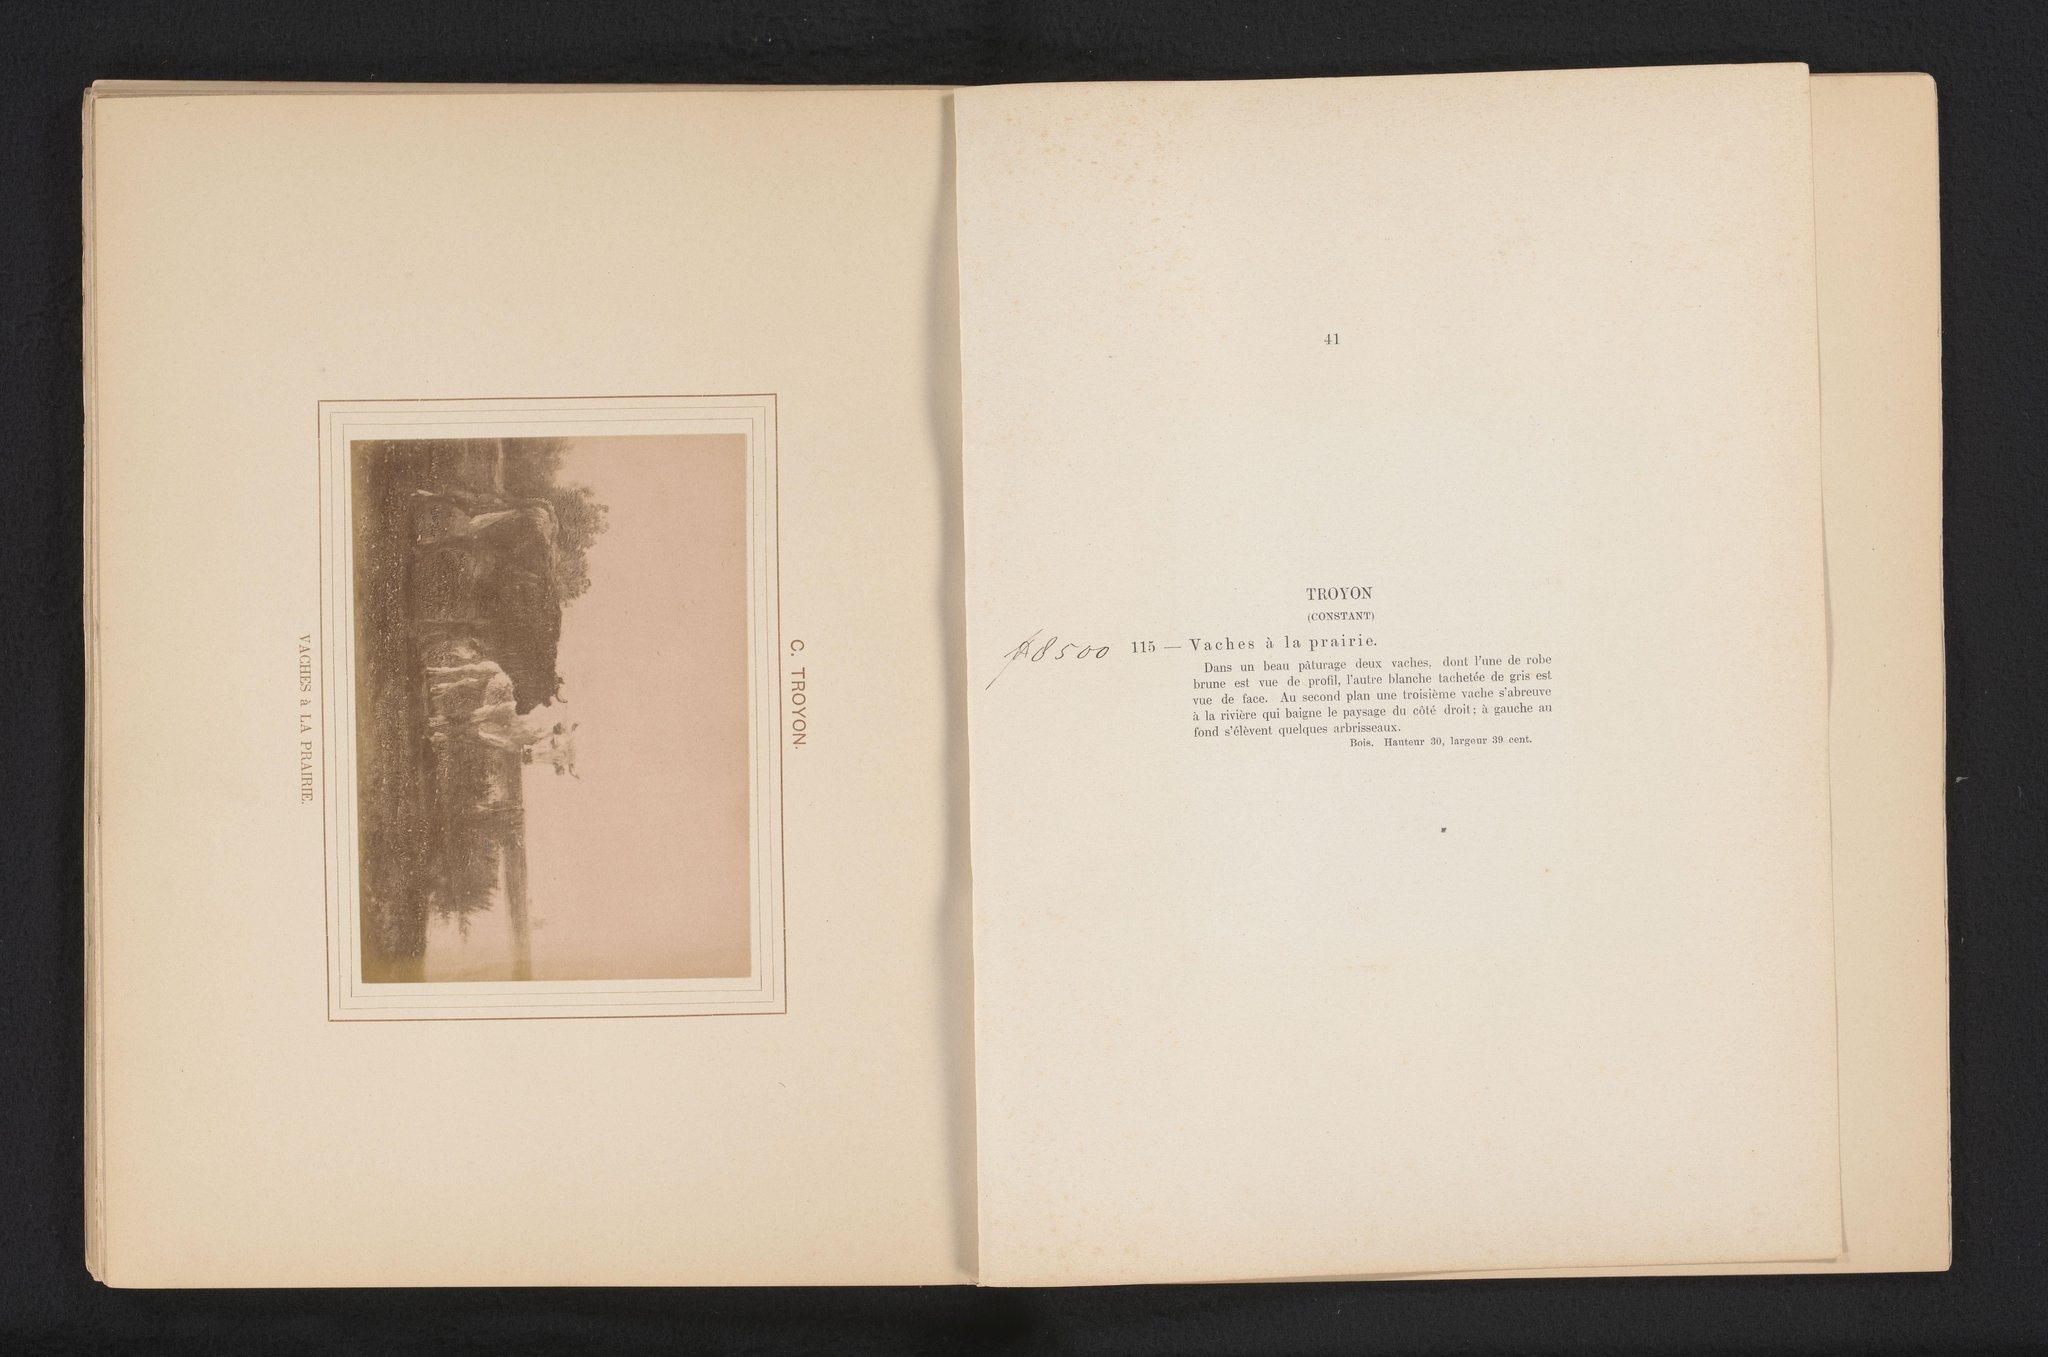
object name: reproduction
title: Fotoreproductie van Vaches à la prairie door Constant Troyon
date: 1878-1883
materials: photographic support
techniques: albumen print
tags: cow, painting, drawing and the graphic arts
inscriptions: inscription: ‘C. Troyon’